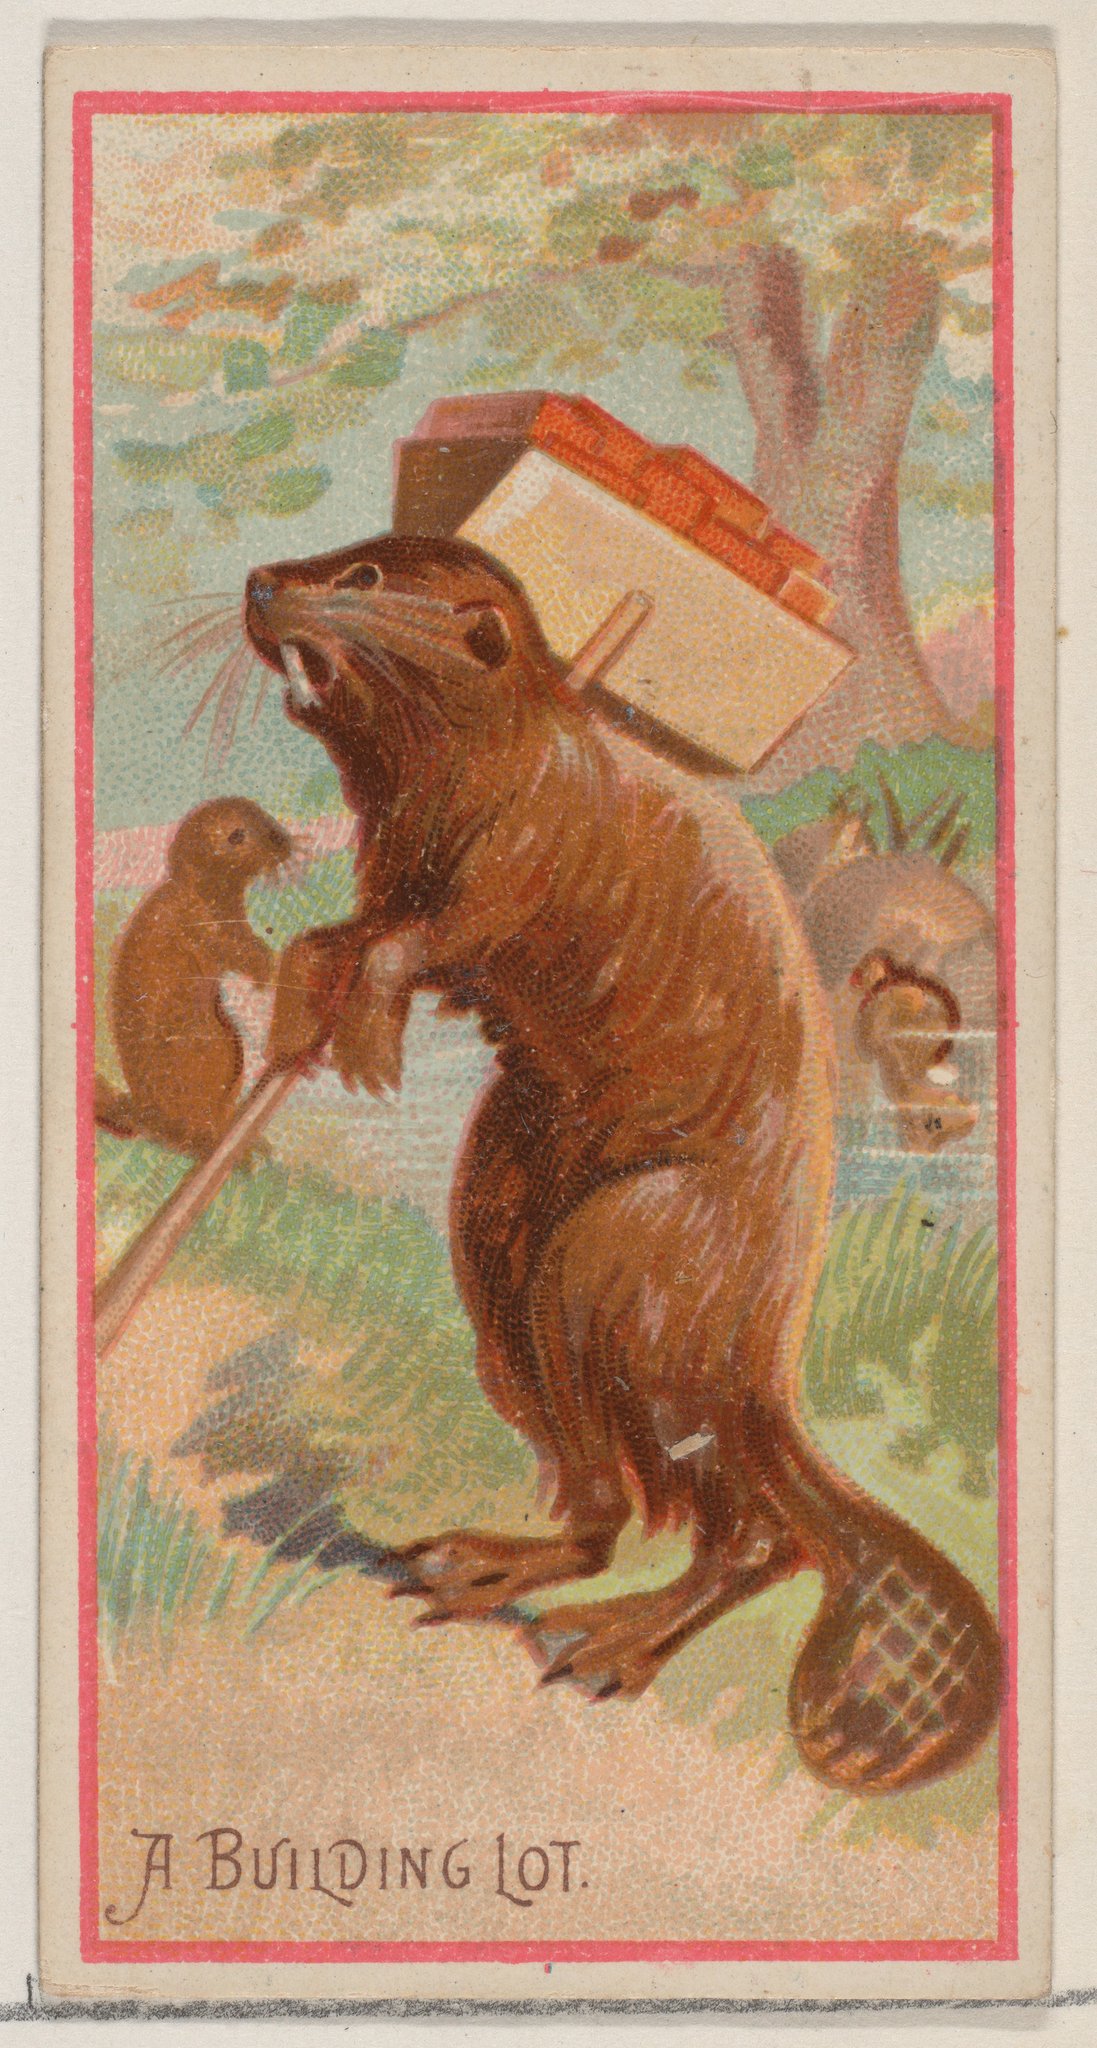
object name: print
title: A Building Lot, from the Jokes series (N87) for Duke brand cigarettes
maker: w. duke, sons & co.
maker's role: publisher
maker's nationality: american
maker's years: 1870-1920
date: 1890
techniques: color lithograph